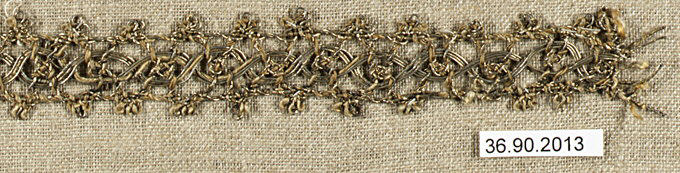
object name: piece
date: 1801-1900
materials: metal thread, silk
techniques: lace